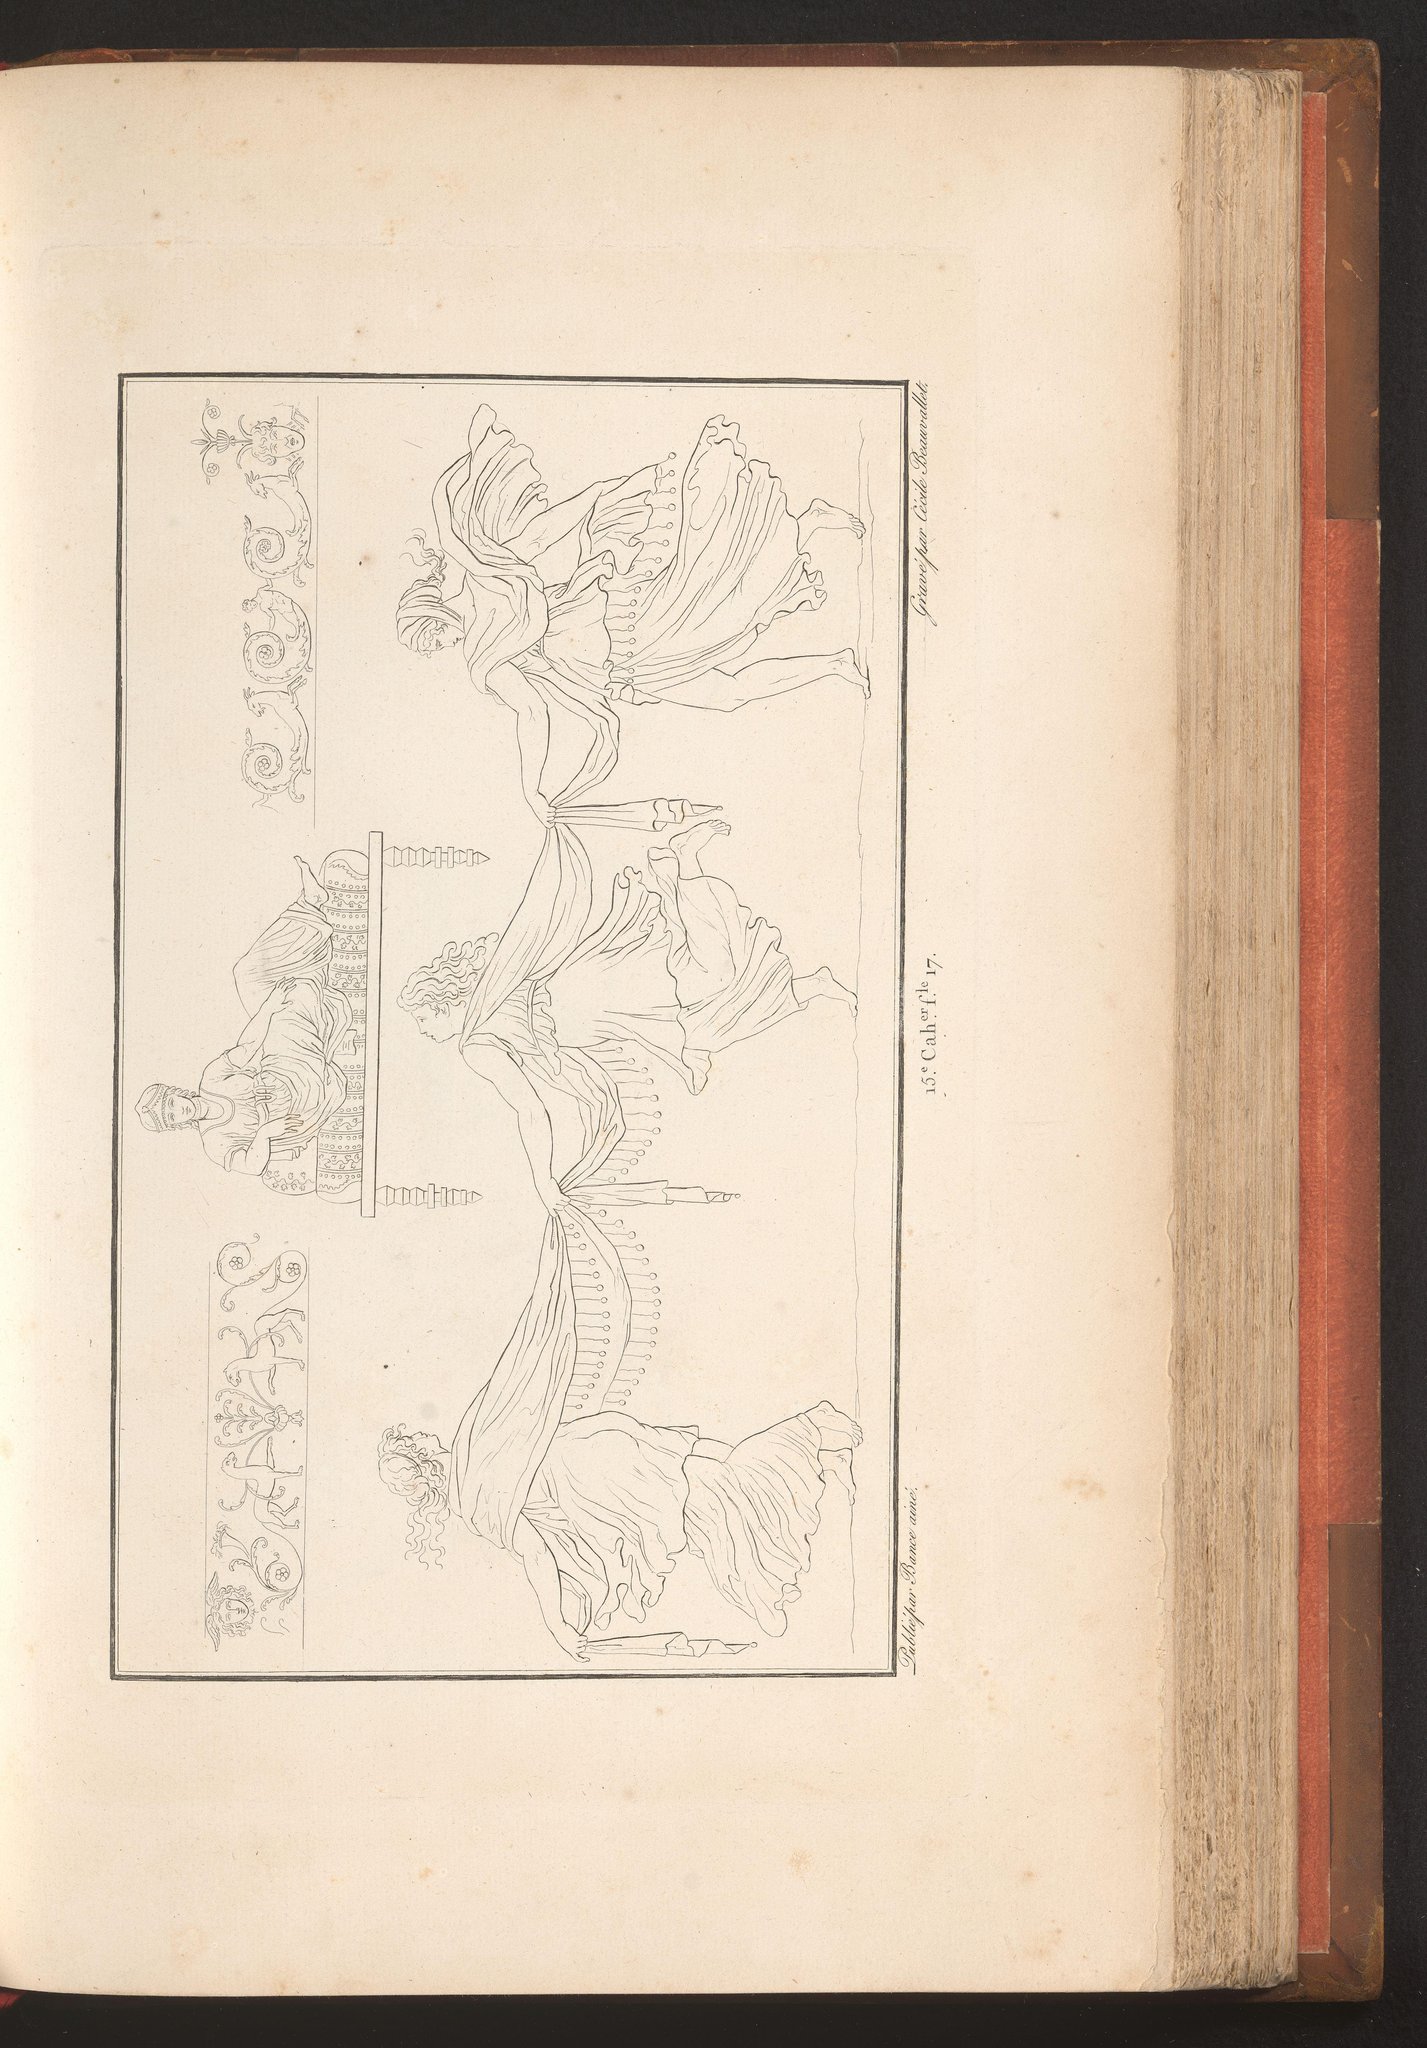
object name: ornament print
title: Dansende vrouwen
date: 1820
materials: paper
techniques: etching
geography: paris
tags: ornaments ~ art, group of women (folk dancing), couch, sofa, settee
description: Ornamentprent met dansende vrouwen en vrouw op ligbed. Onderdeel (15e. Cah. f.le 17) van het prentalbum met twee series van in totaal 138 ornamentprenten door Beauvallet en Normand, 'Fragmens d'Ornemens dans le Style Antique'.